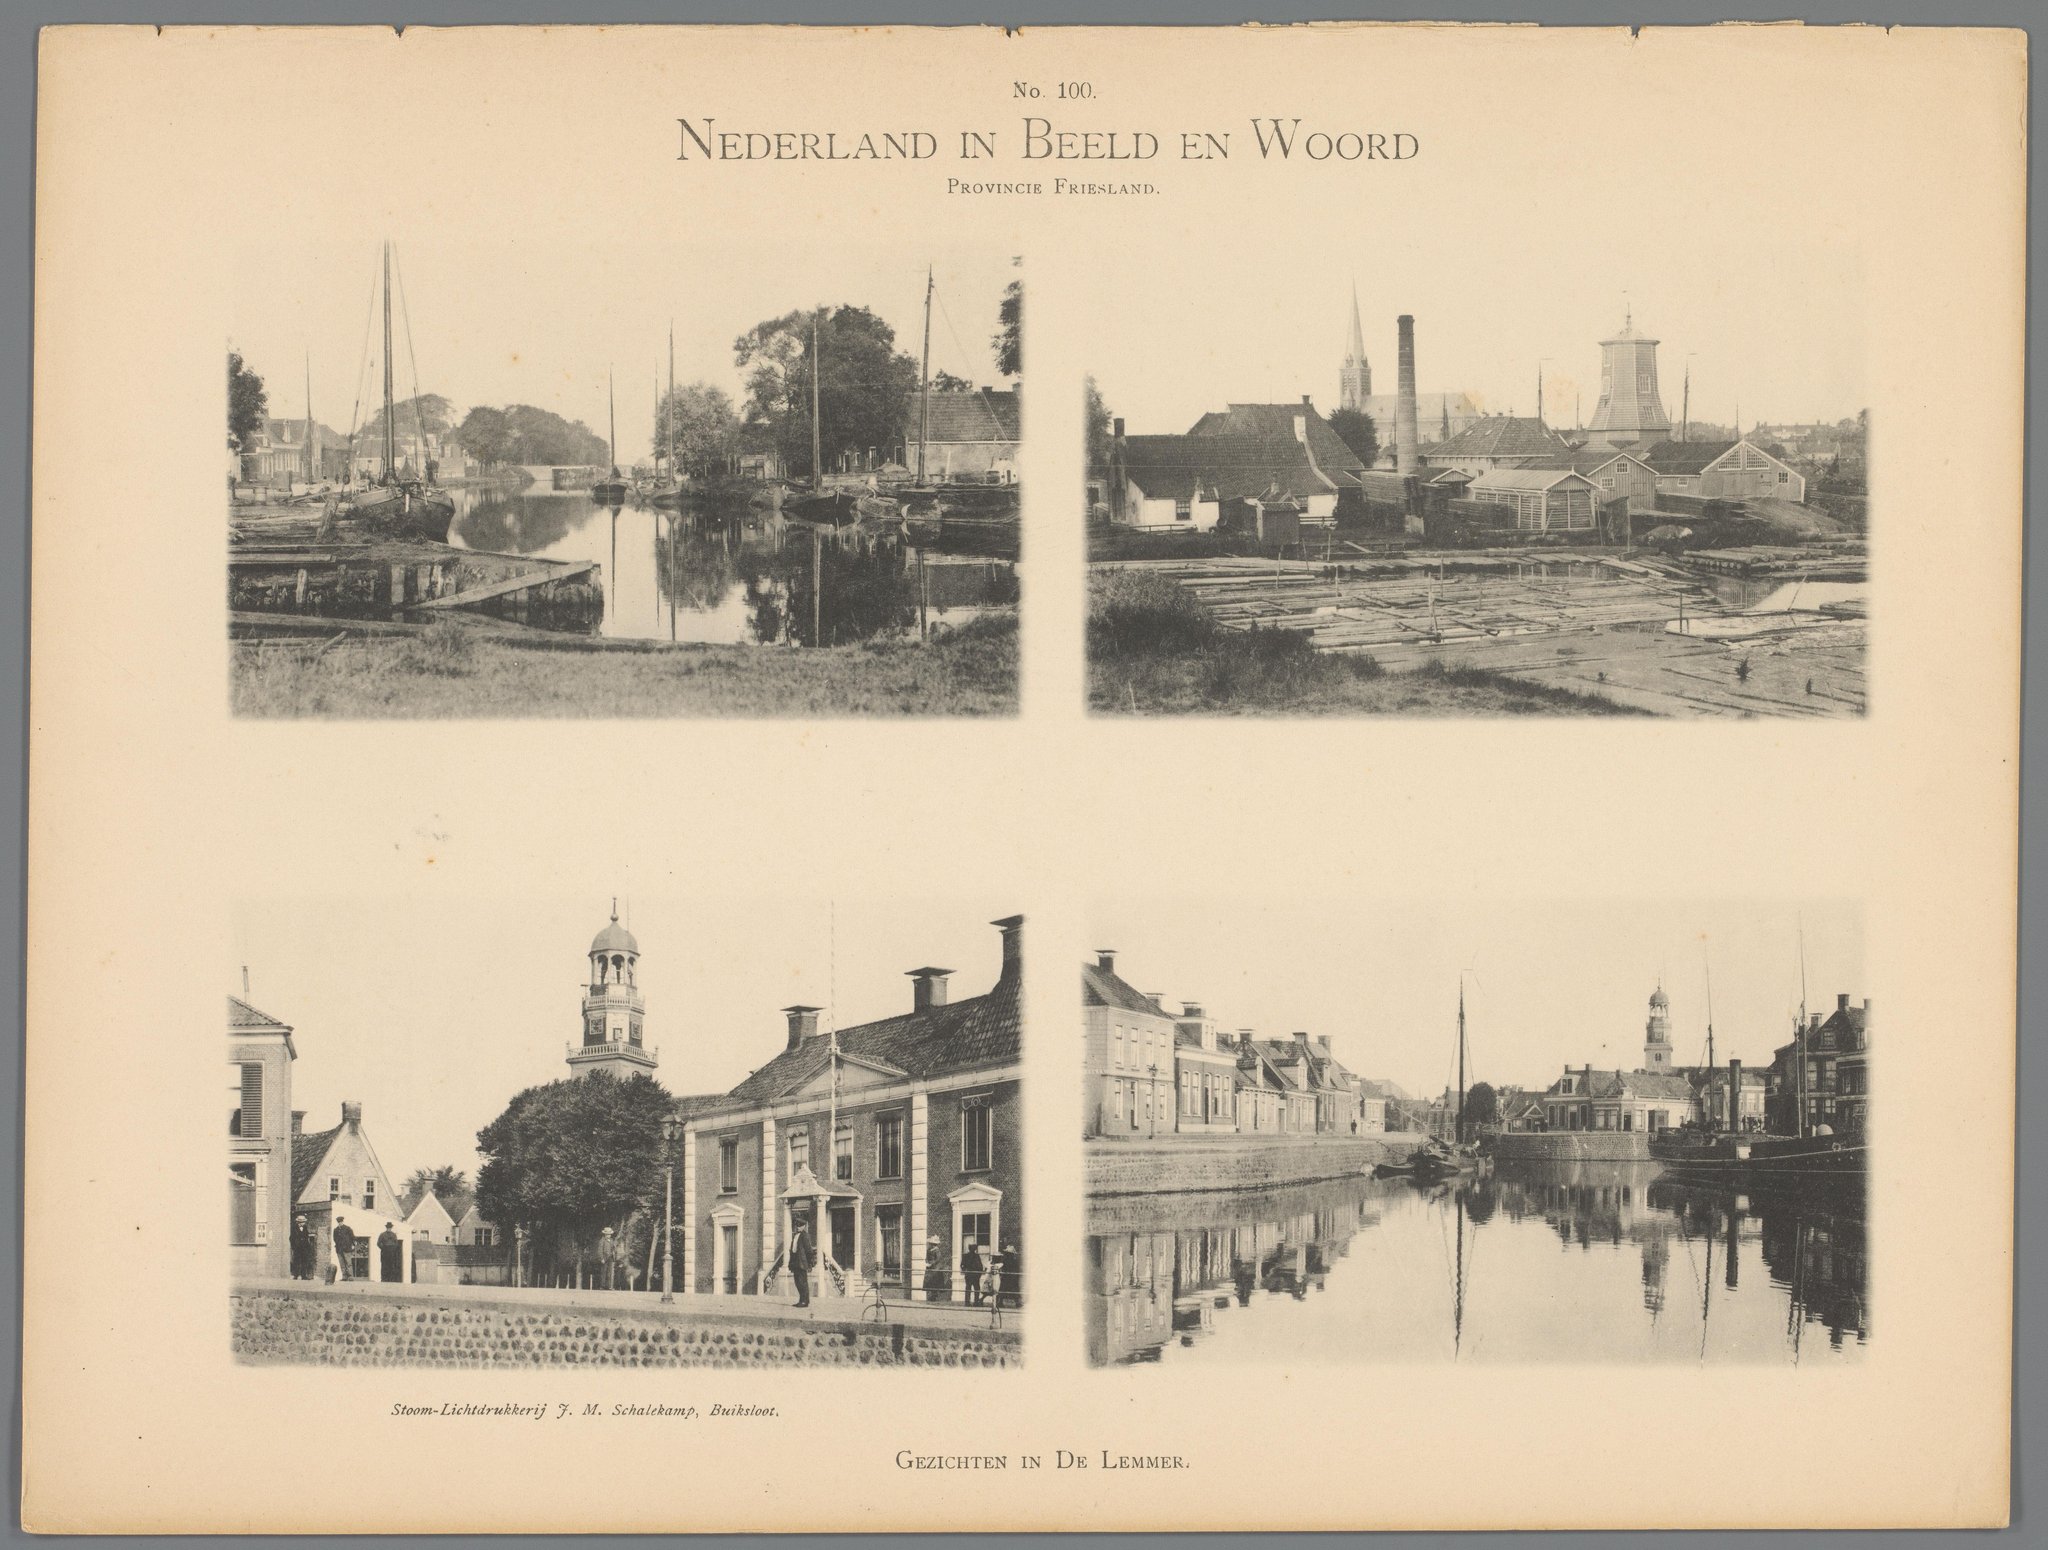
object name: photomechanical print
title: Vier gezichten op Lemmer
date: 1890-1895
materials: cardboard, paper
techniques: photograph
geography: lemmer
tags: industries ~ wood, village, canals, waters (in city)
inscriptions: number: ‘No. 100.’